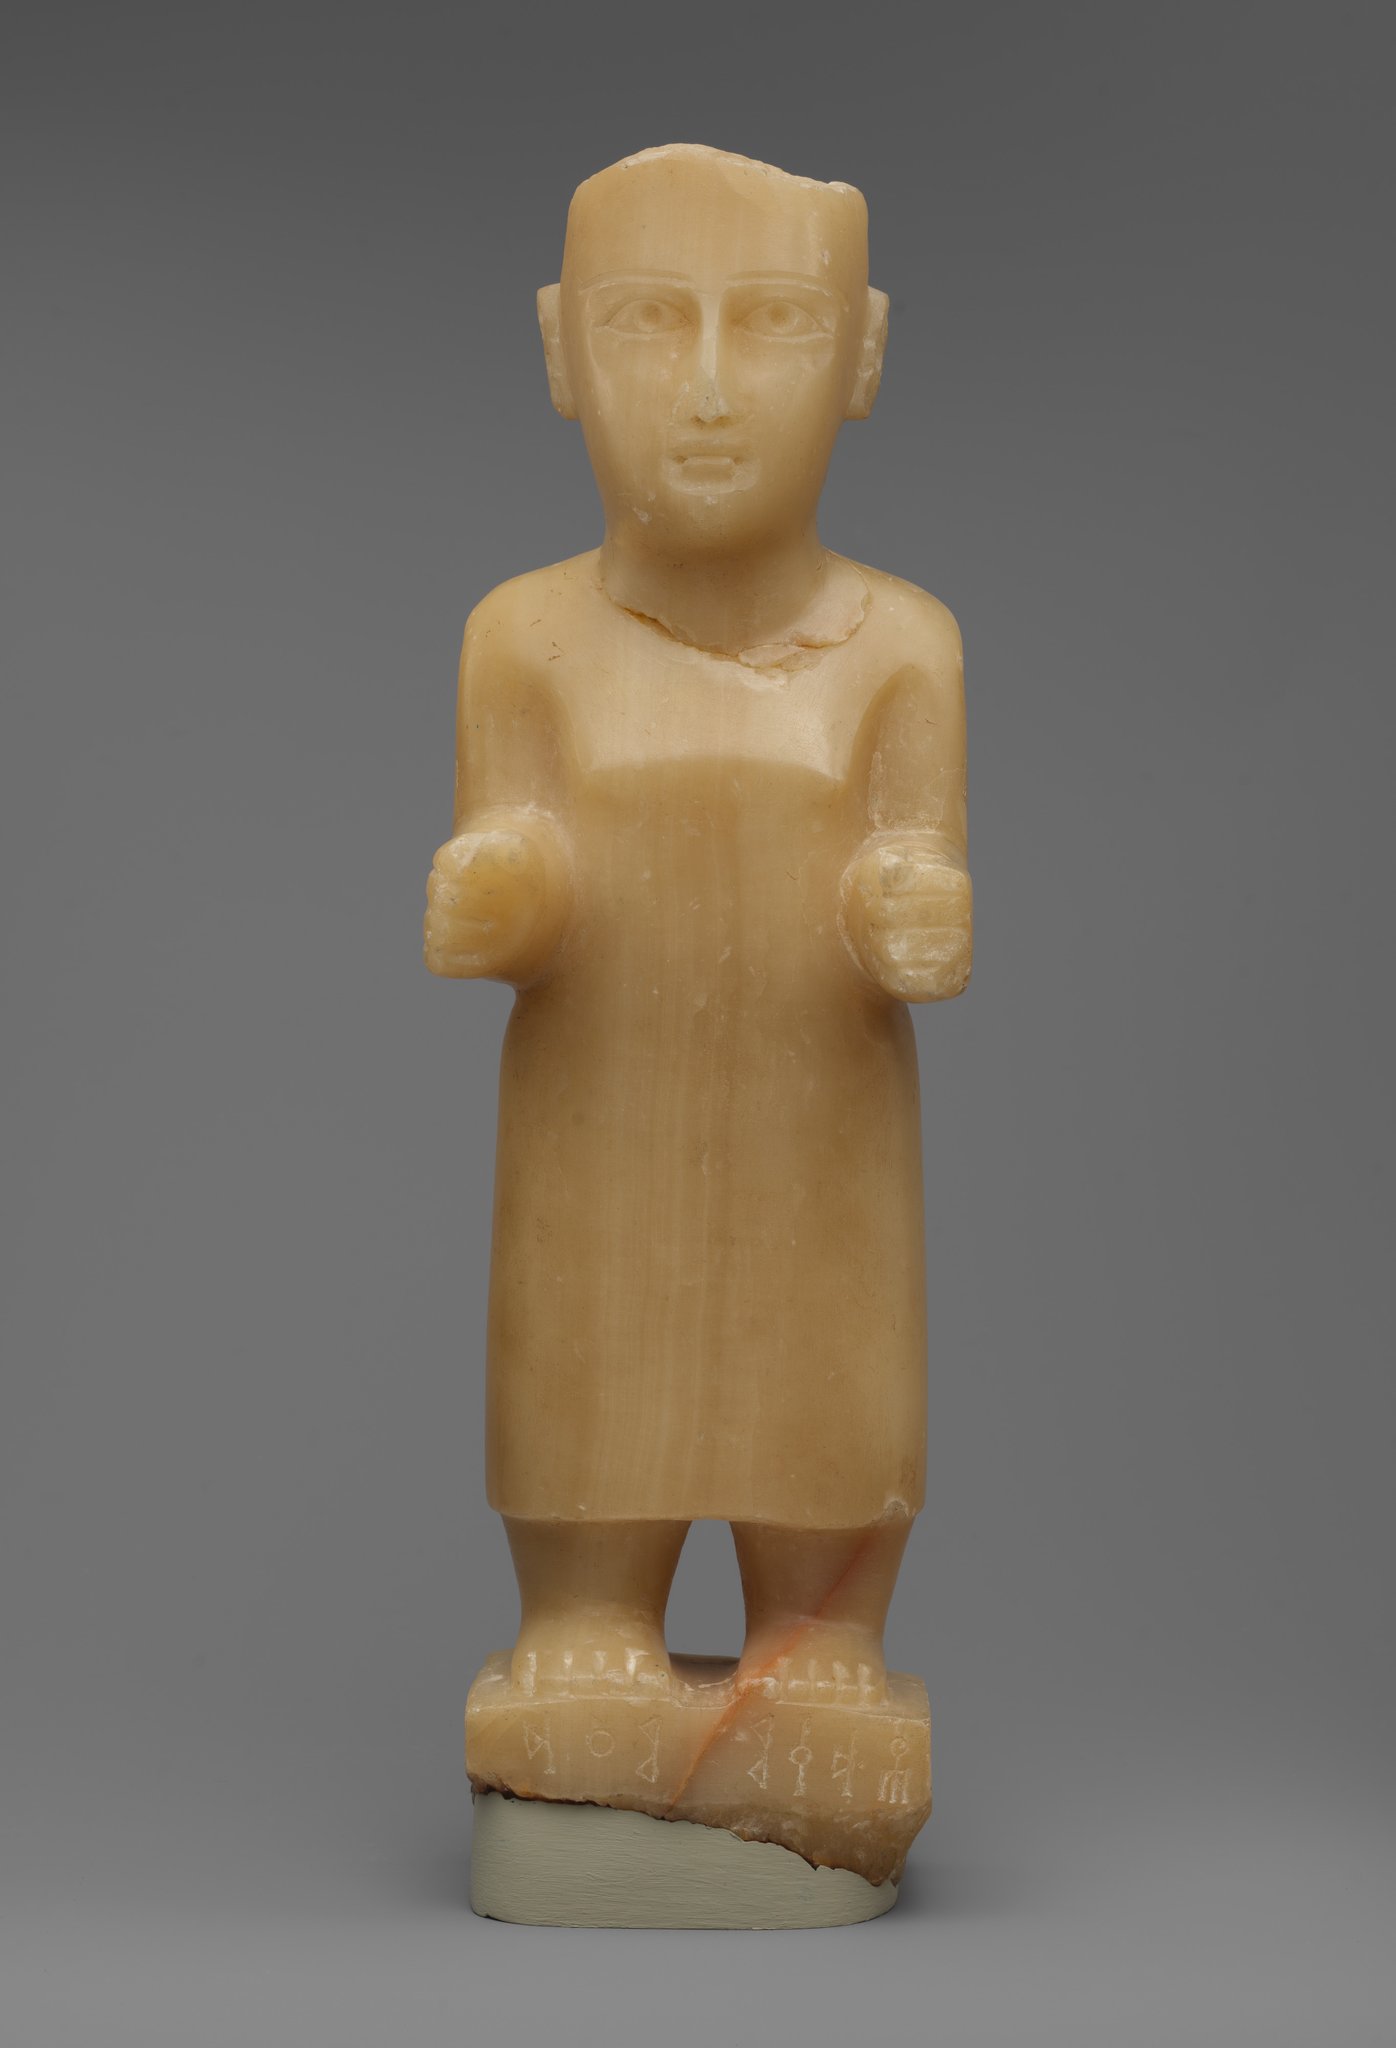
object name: sculpture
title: Standing male figure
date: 333-1 BCE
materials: alabaster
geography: southwestern arabia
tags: men